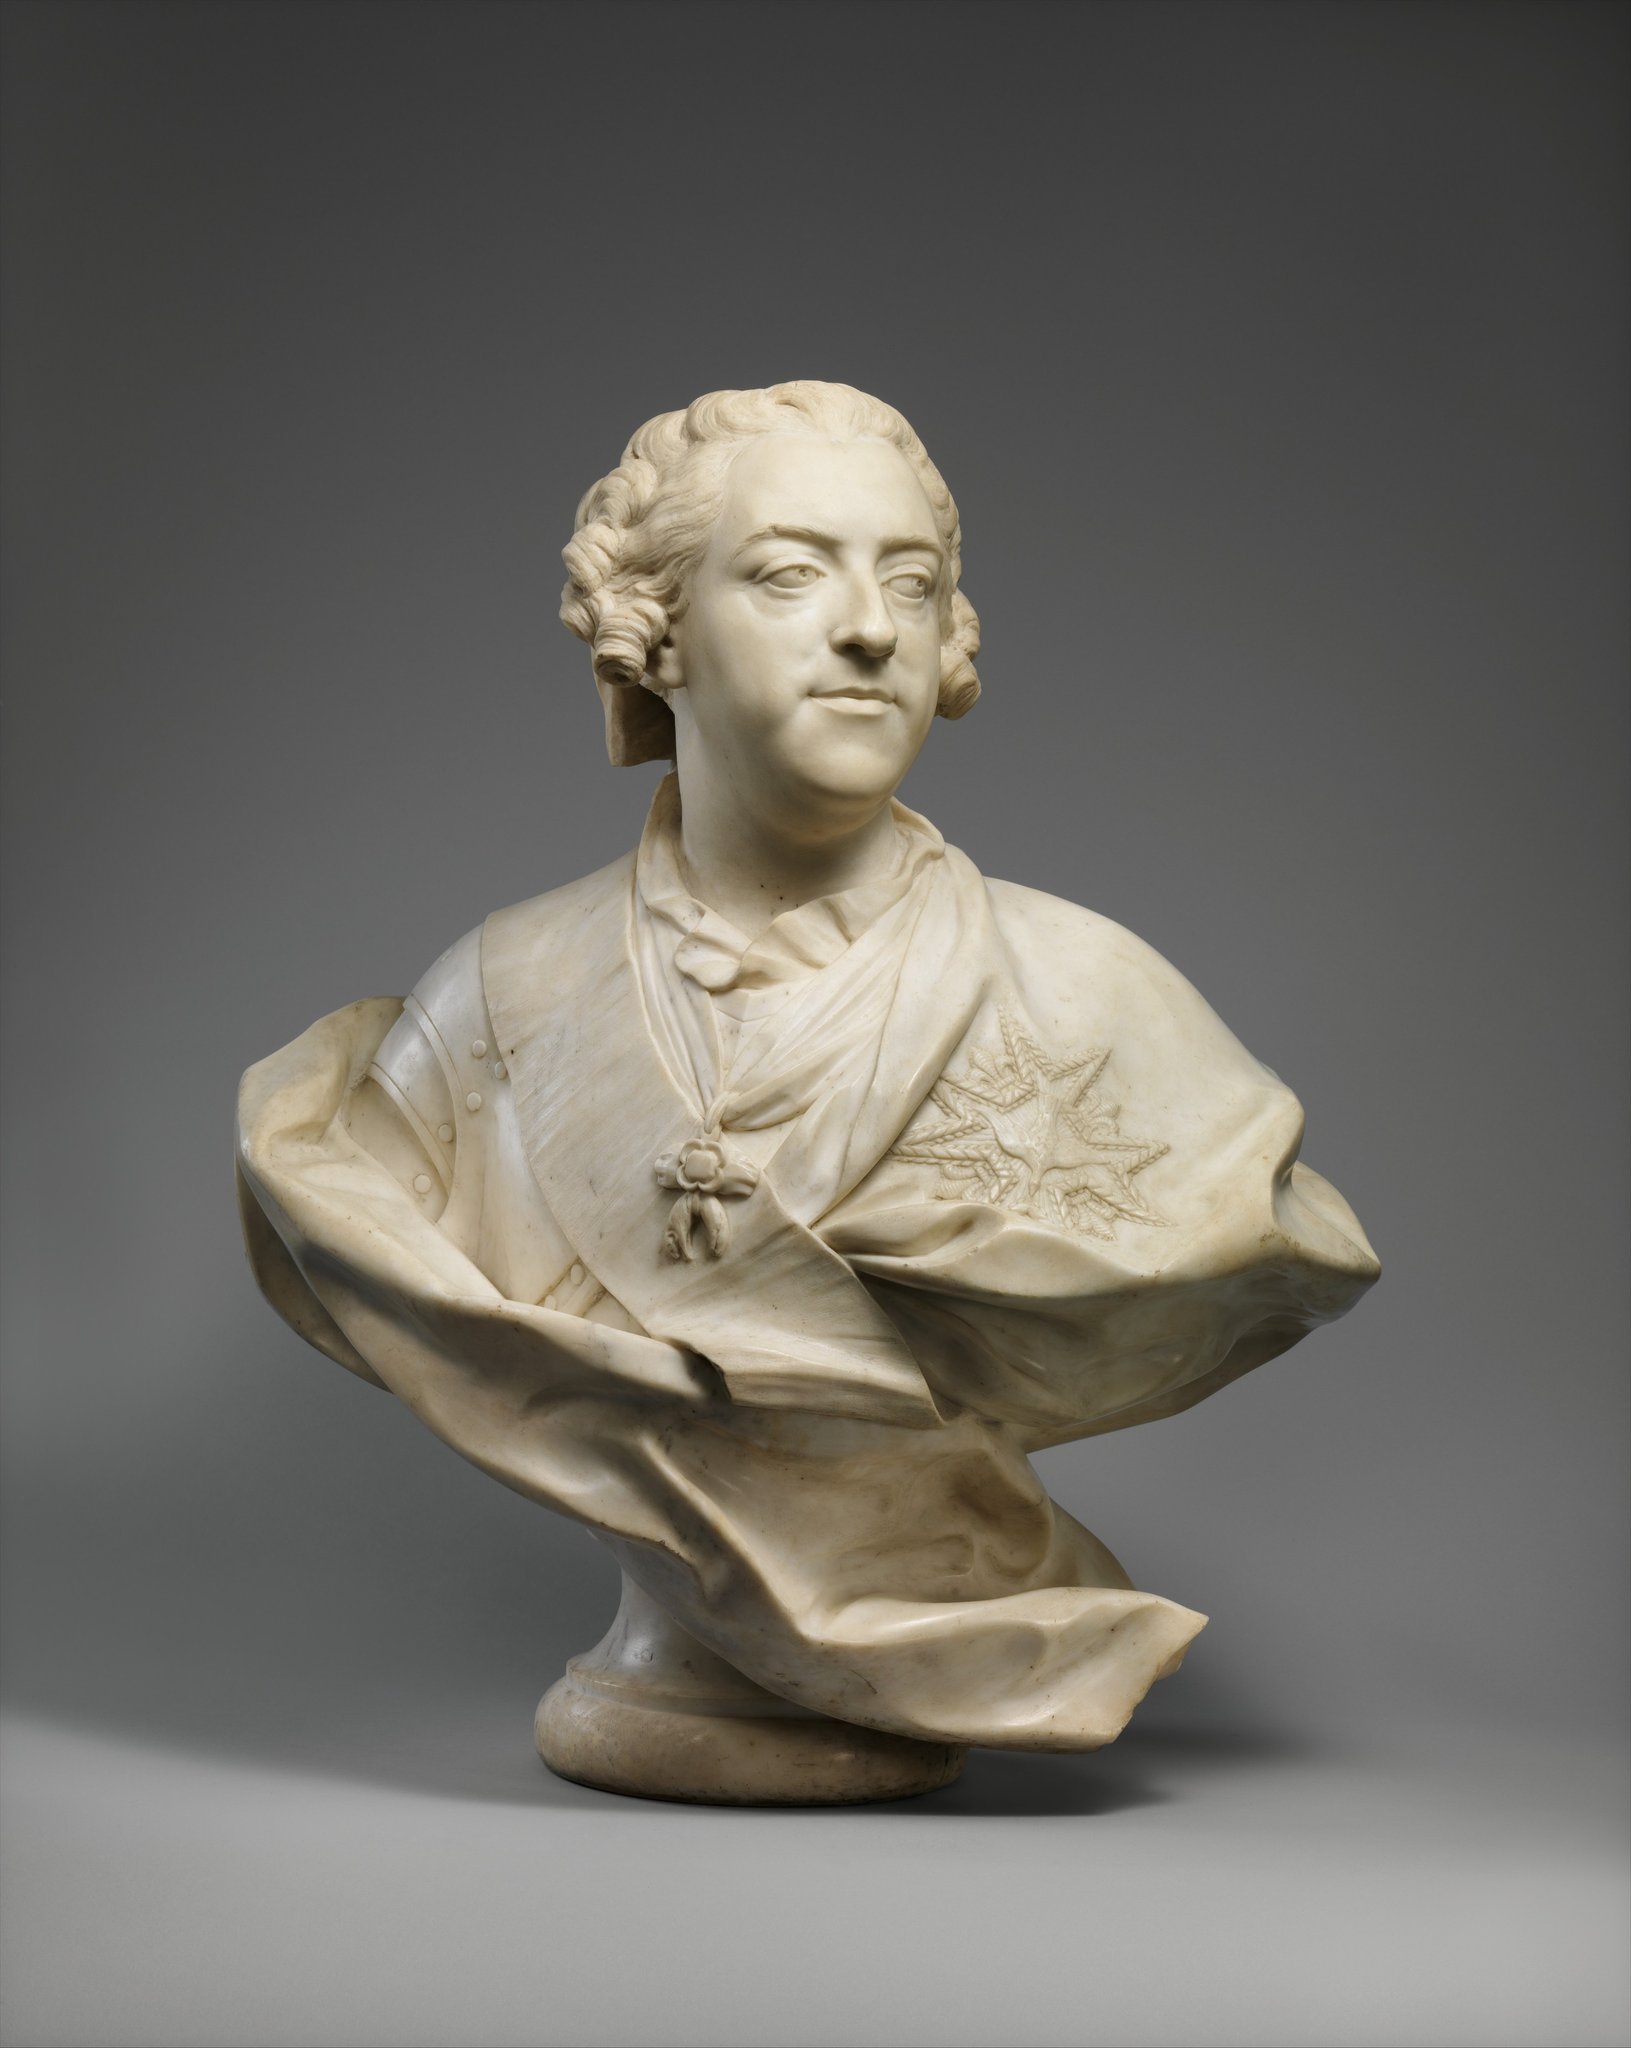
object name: bust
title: Louis XV (1710–1774), King of France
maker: jean-baptiste lemoyne the younger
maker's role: artist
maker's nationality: french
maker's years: 1704-1778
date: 1757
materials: marble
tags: kings